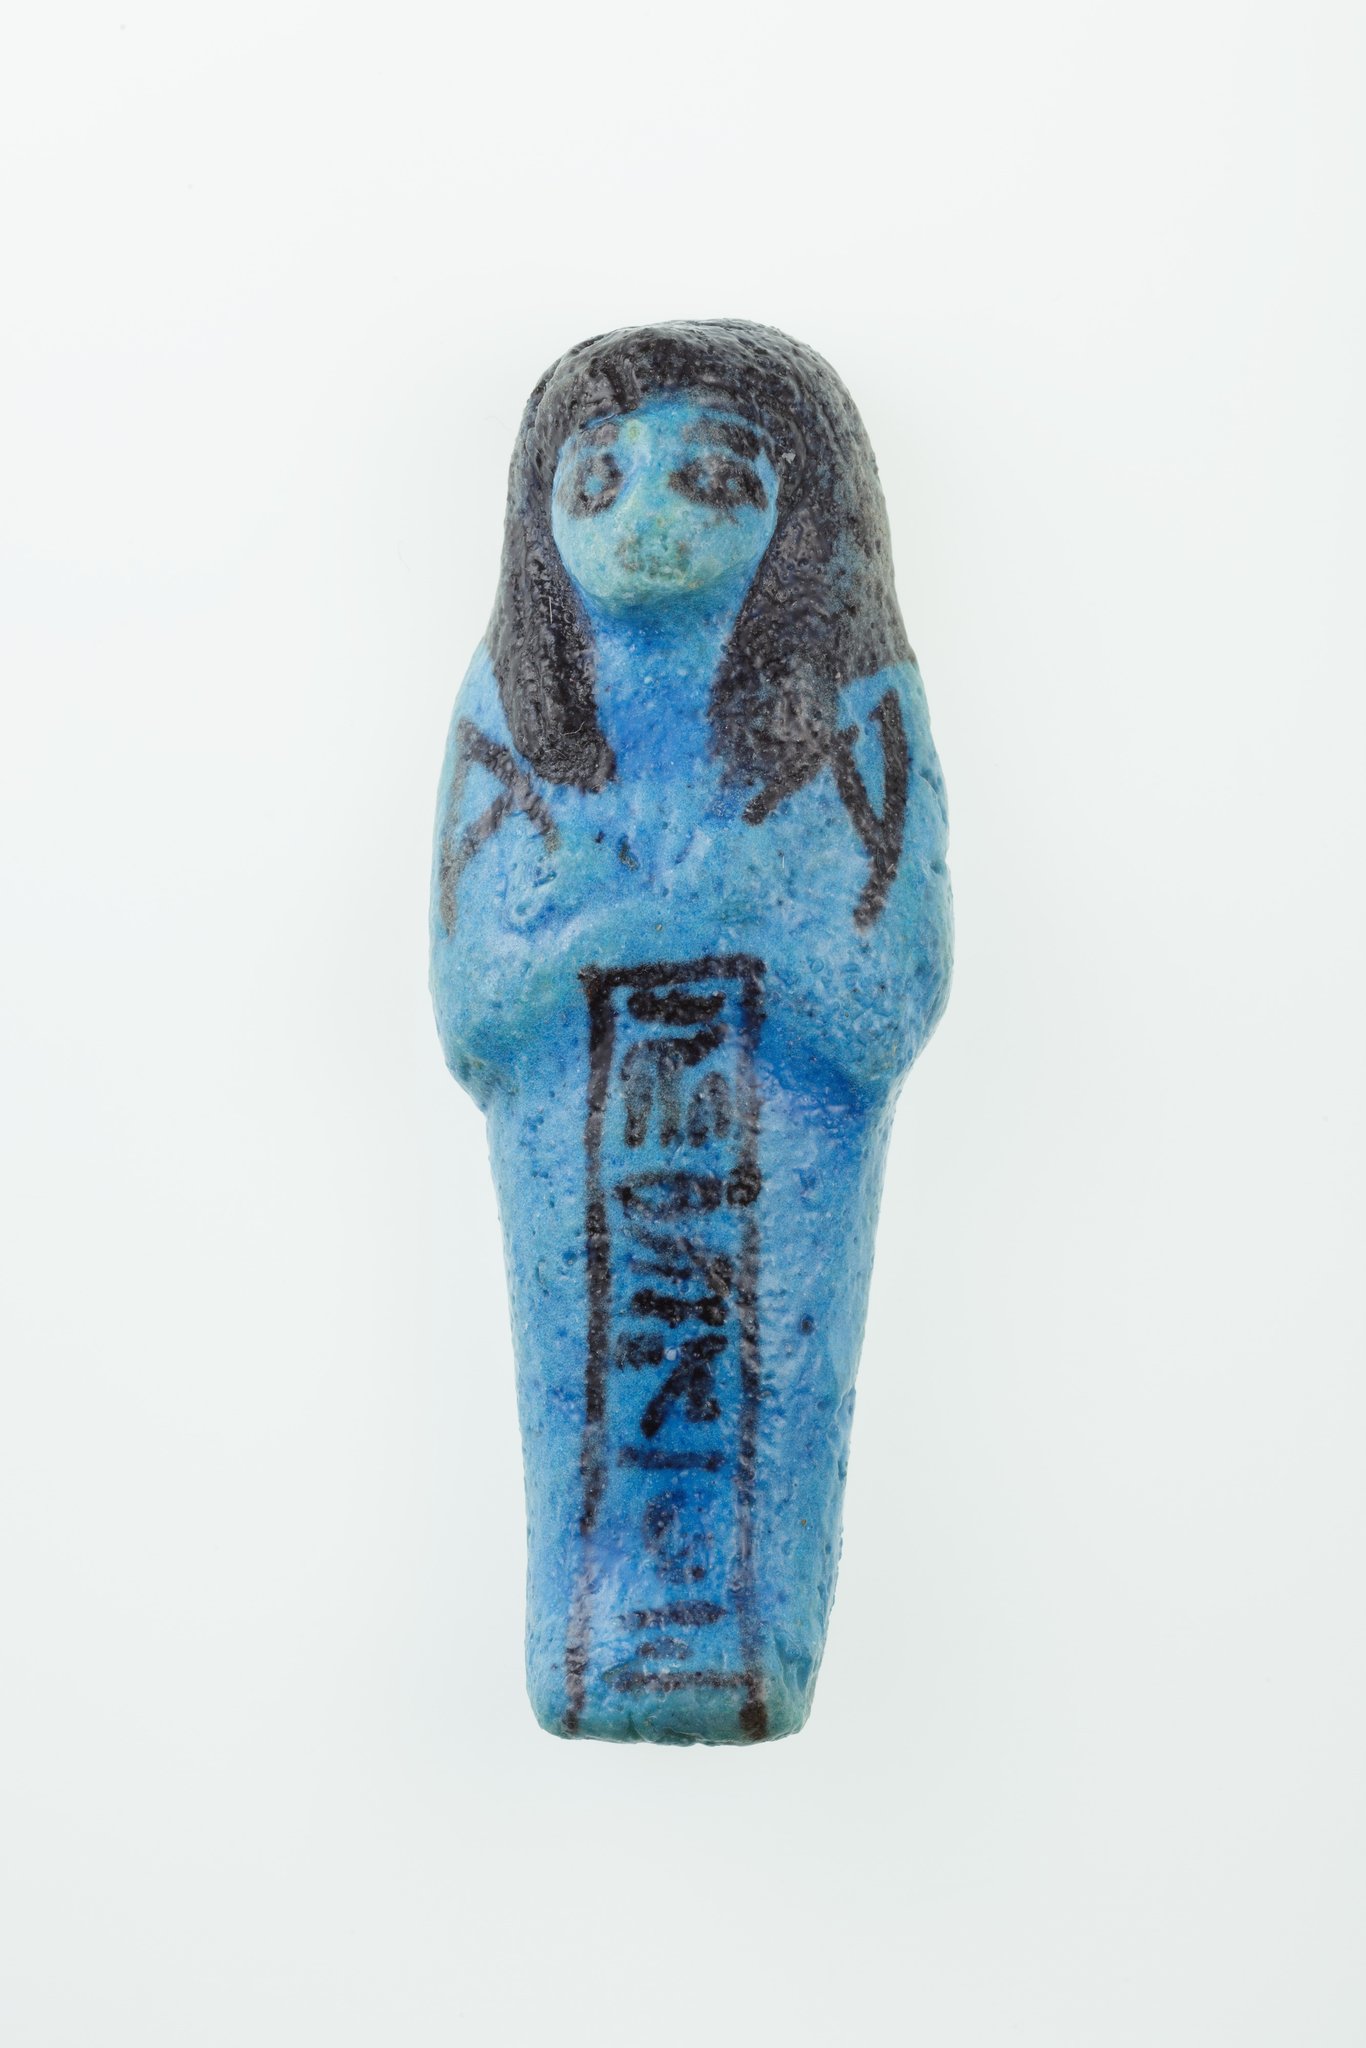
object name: shabti, worker, nauny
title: Worker Shabti of Nauny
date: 1050 BCE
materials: faience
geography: egypt